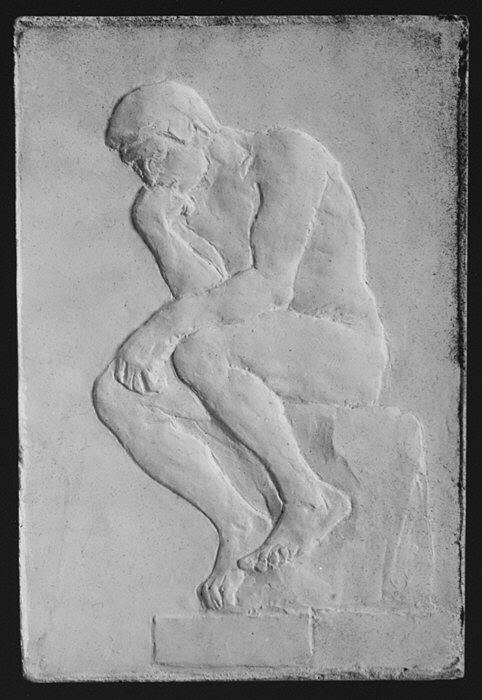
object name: relief mold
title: Positive and negative molds of a relief after Rodin's Thinker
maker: victor peter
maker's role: artist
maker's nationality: french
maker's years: 1840-1918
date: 1900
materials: plaster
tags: contemplation,male nudes